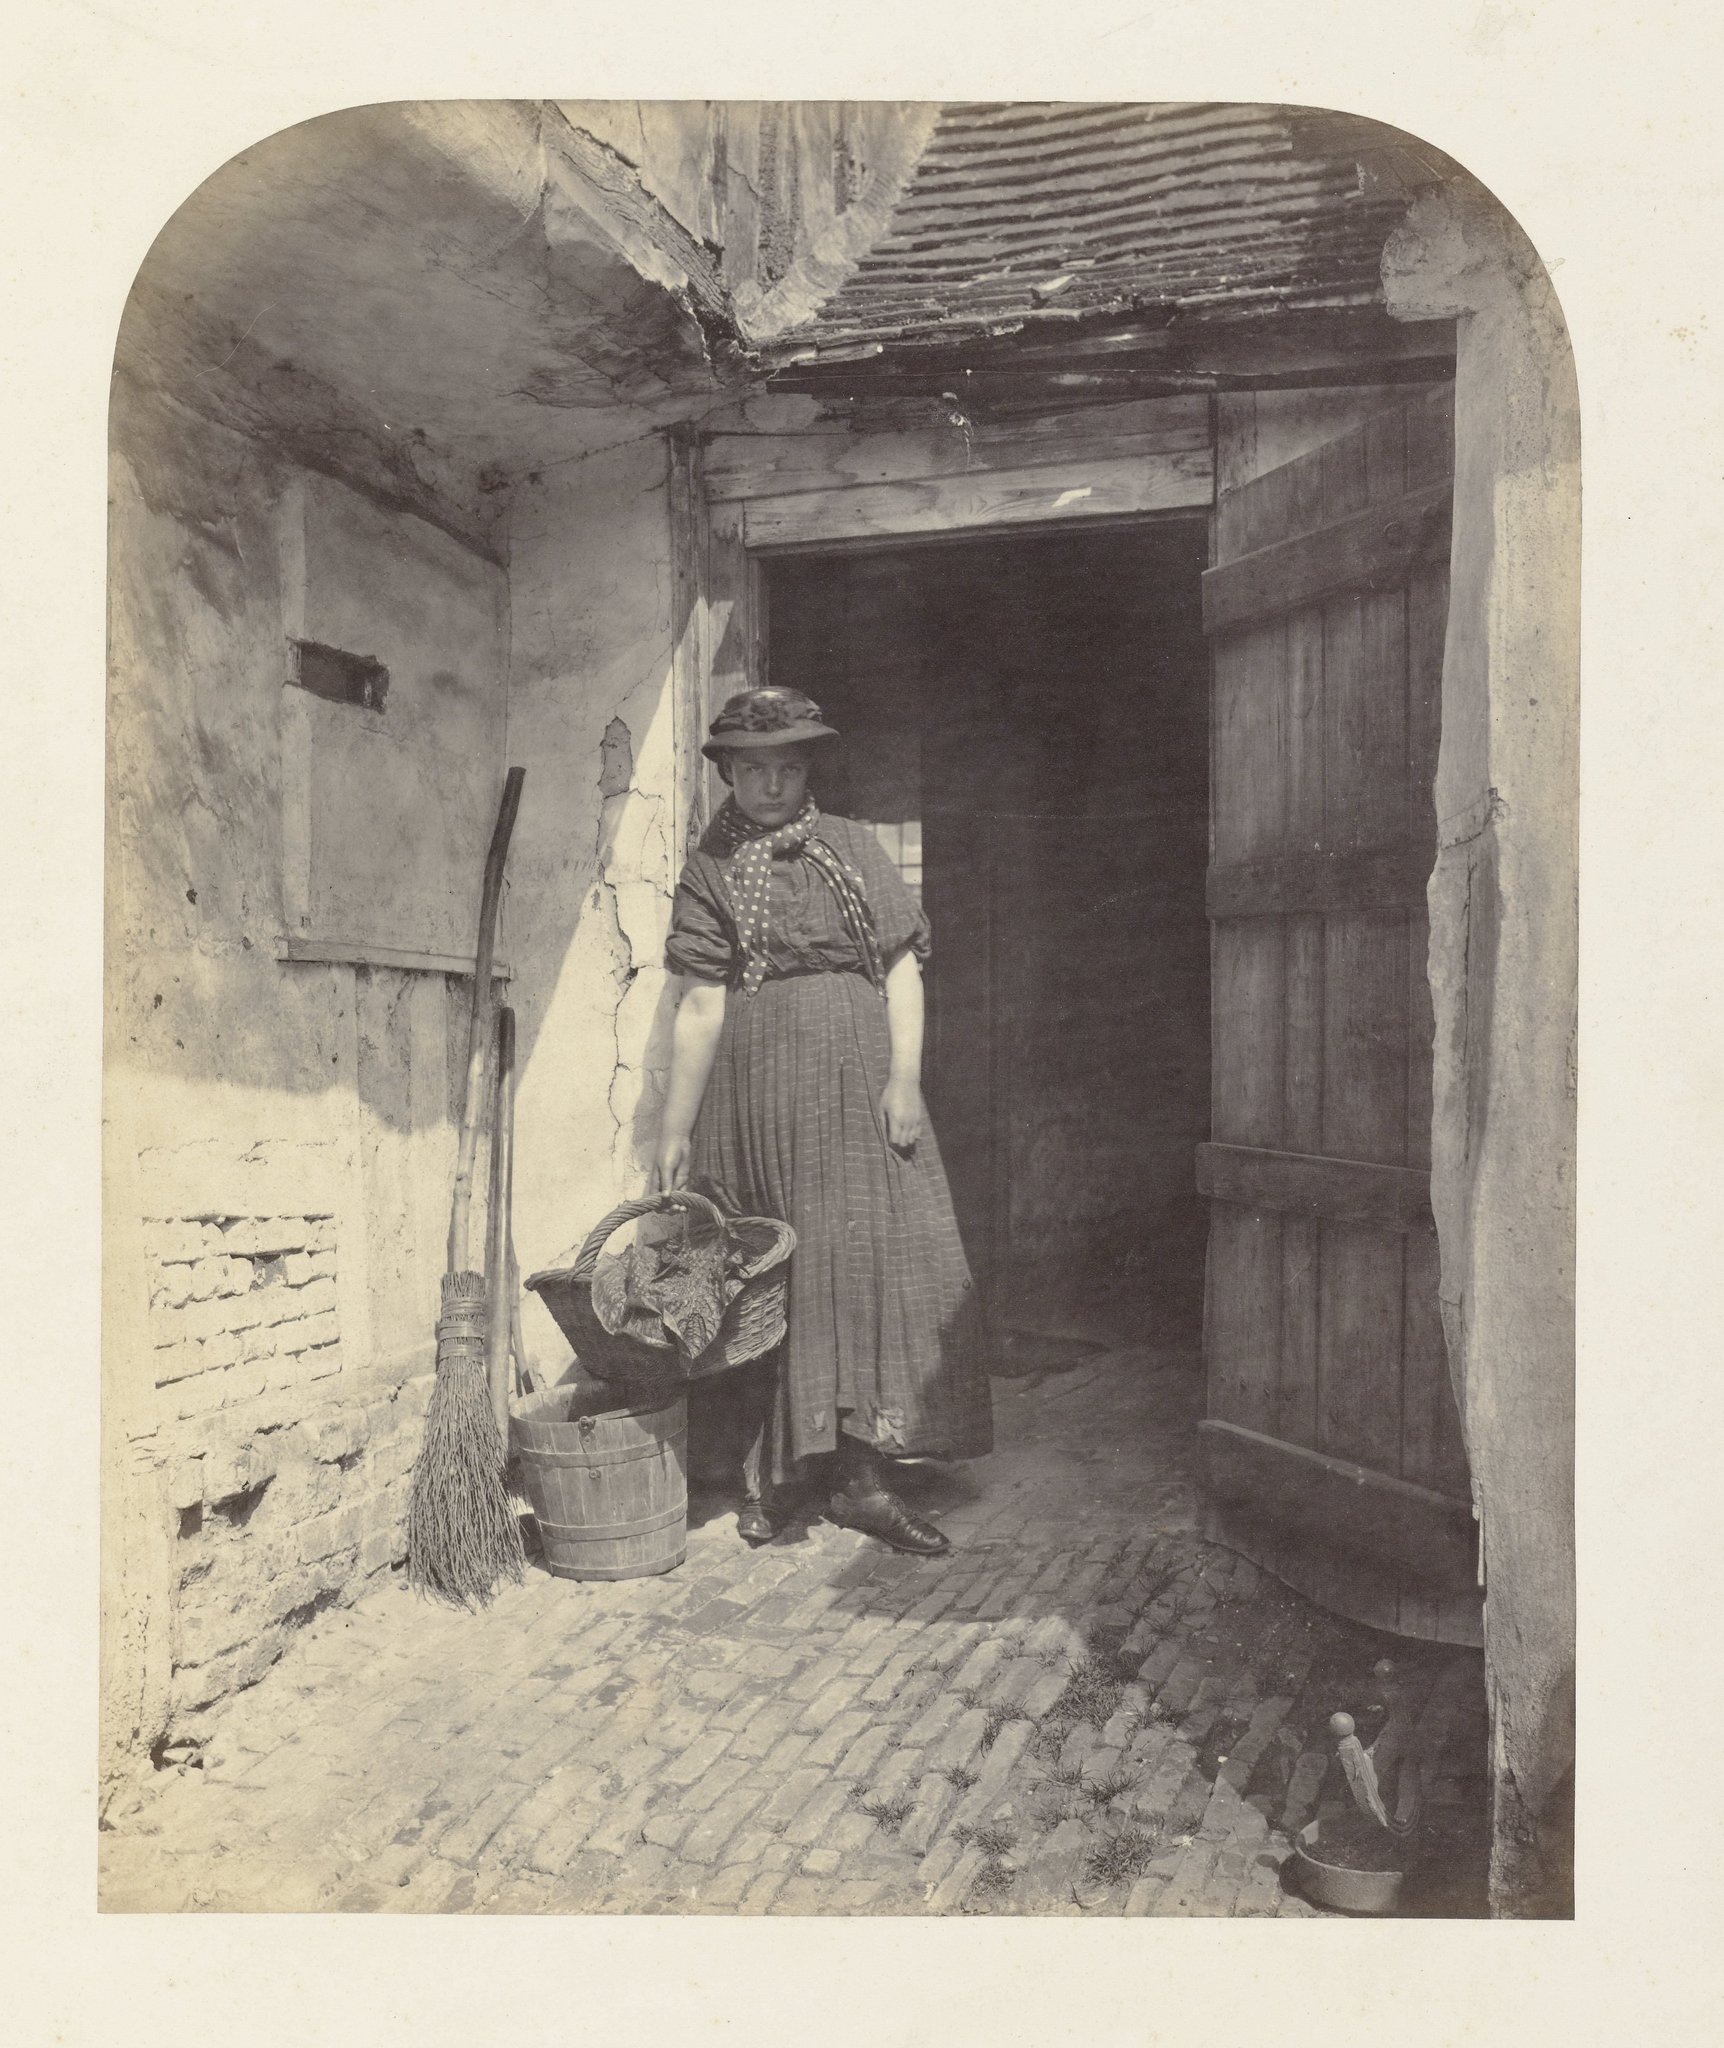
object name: photograph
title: Portret van een onbekende jonge vrouw in een deuropening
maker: Anonymous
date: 1855-1900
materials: cardboard, paper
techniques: albumen print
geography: great britain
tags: adult woman, anonymous historical person portrayed, great britain